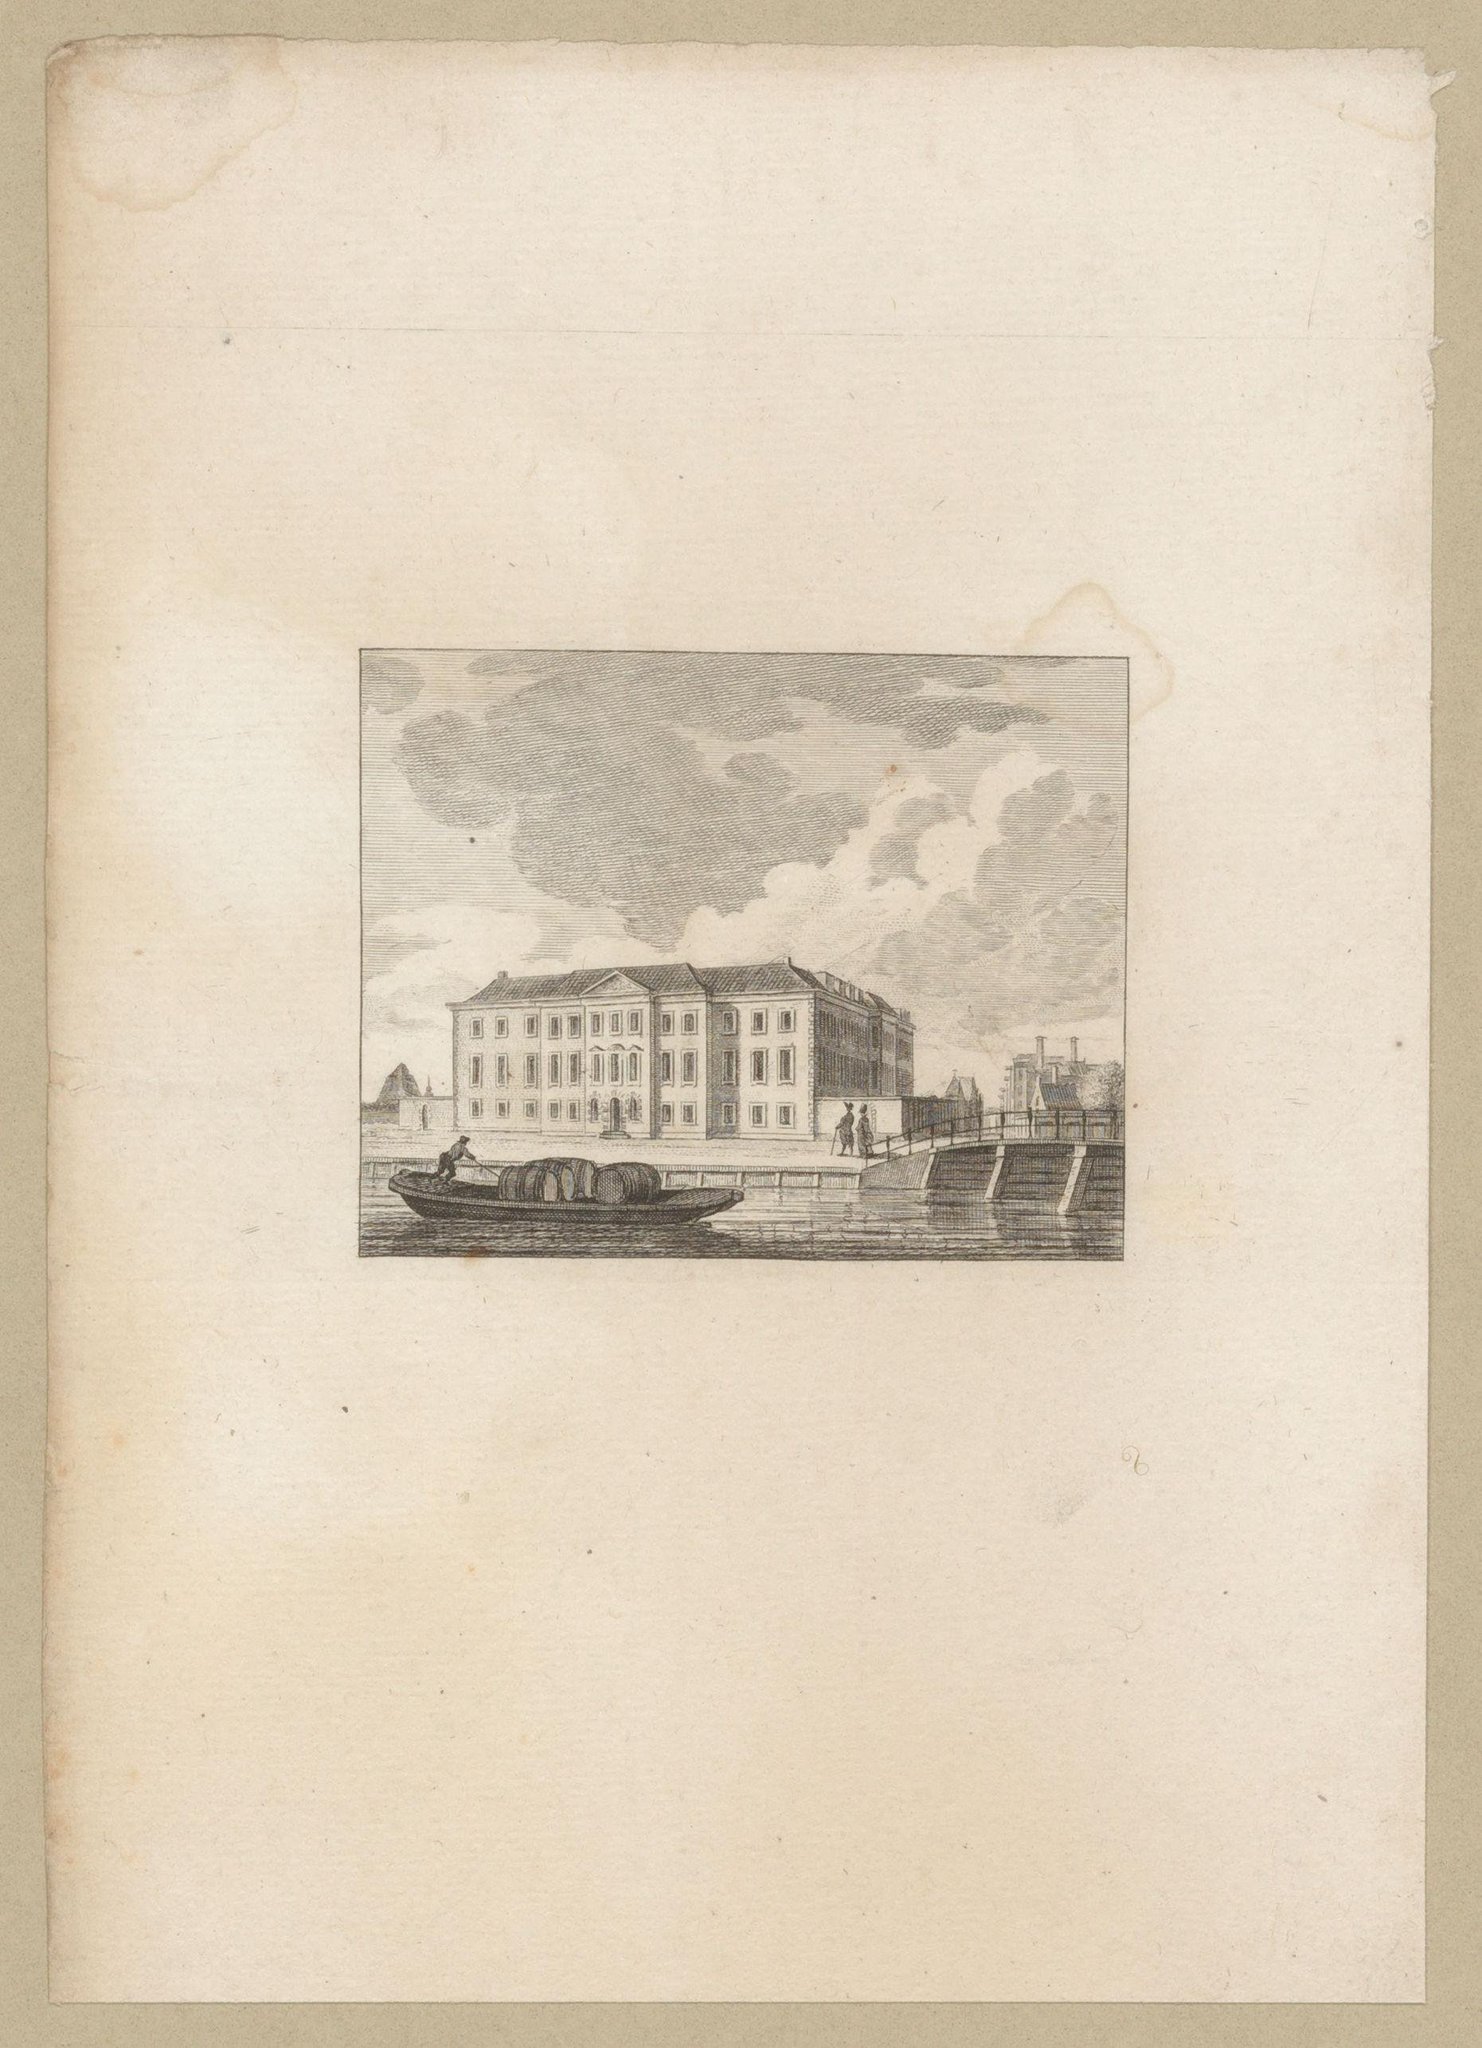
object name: print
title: Gezicht op het Nieuwe Werkhuis te Amsterdam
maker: cornelis brouwer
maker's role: print maker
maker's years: 1731-1803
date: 1782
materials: paper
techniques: etching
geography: northern netherlands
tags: prison, jail, canals, waters (in city), workhouse, penal camp, penitentiary, chain gang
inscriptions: collector's mark: Lugt 1641b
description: Latere staat van prent gebruikt in: Beschryving van Amsterdam verkort. Amsterdam: Hendrik Gartman en Izaak de Jongh, 1782. En in: Beschryving van Amsterdam verkort. Amsterdam: Johannes Wessing Willemsz. en Johannes van der Hey, 1788.